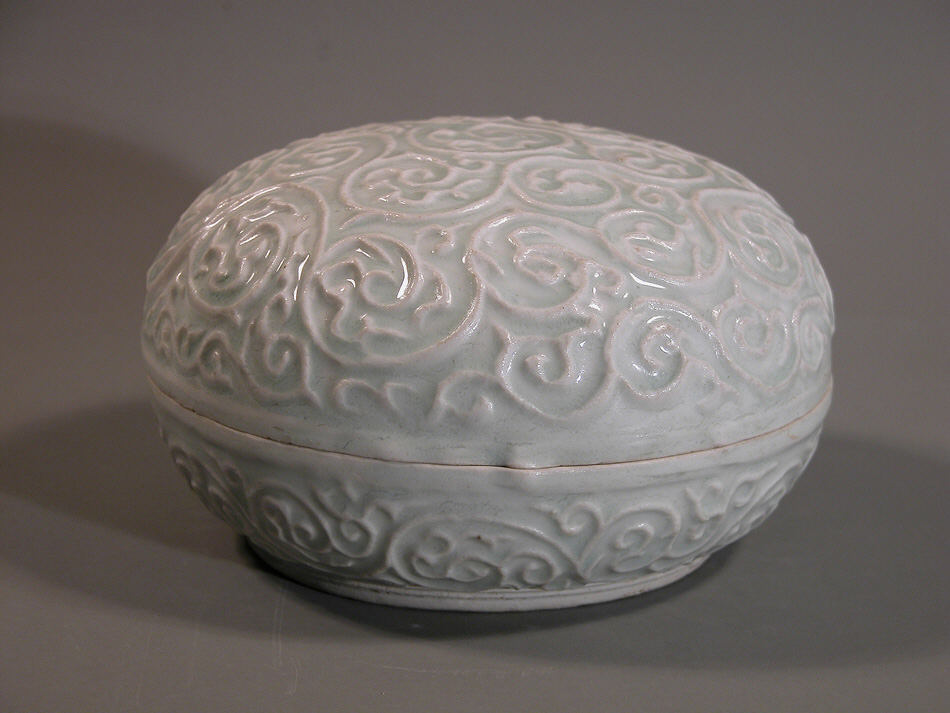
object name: box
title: Circular Box and Cover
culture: chinese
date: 1301-1400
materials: glaze, stoneware